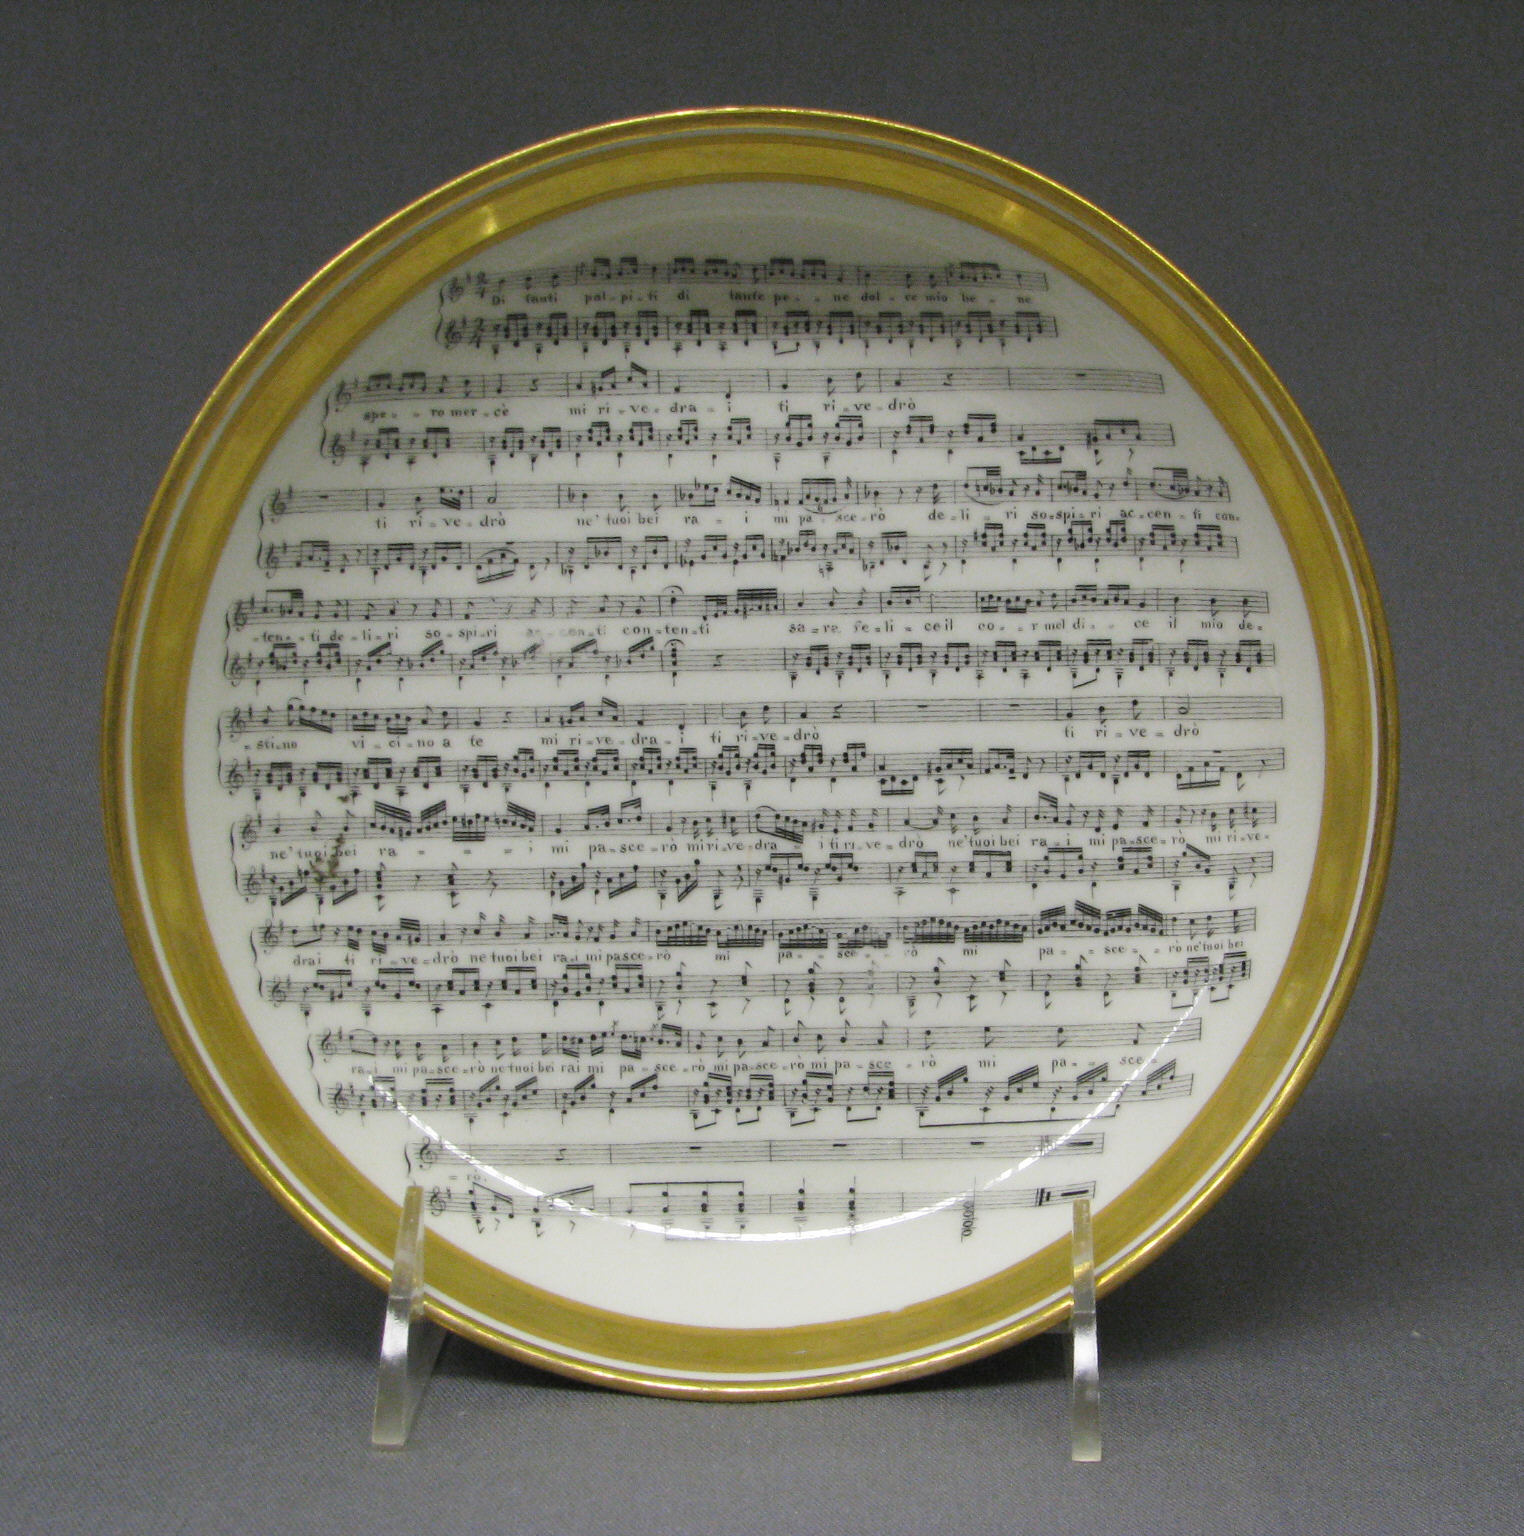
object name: saucer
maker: imperial porcelain manufactory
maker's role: manufactory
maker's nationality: austrian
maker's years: 1744-1864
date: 1817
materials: hard paste porcelain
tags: music